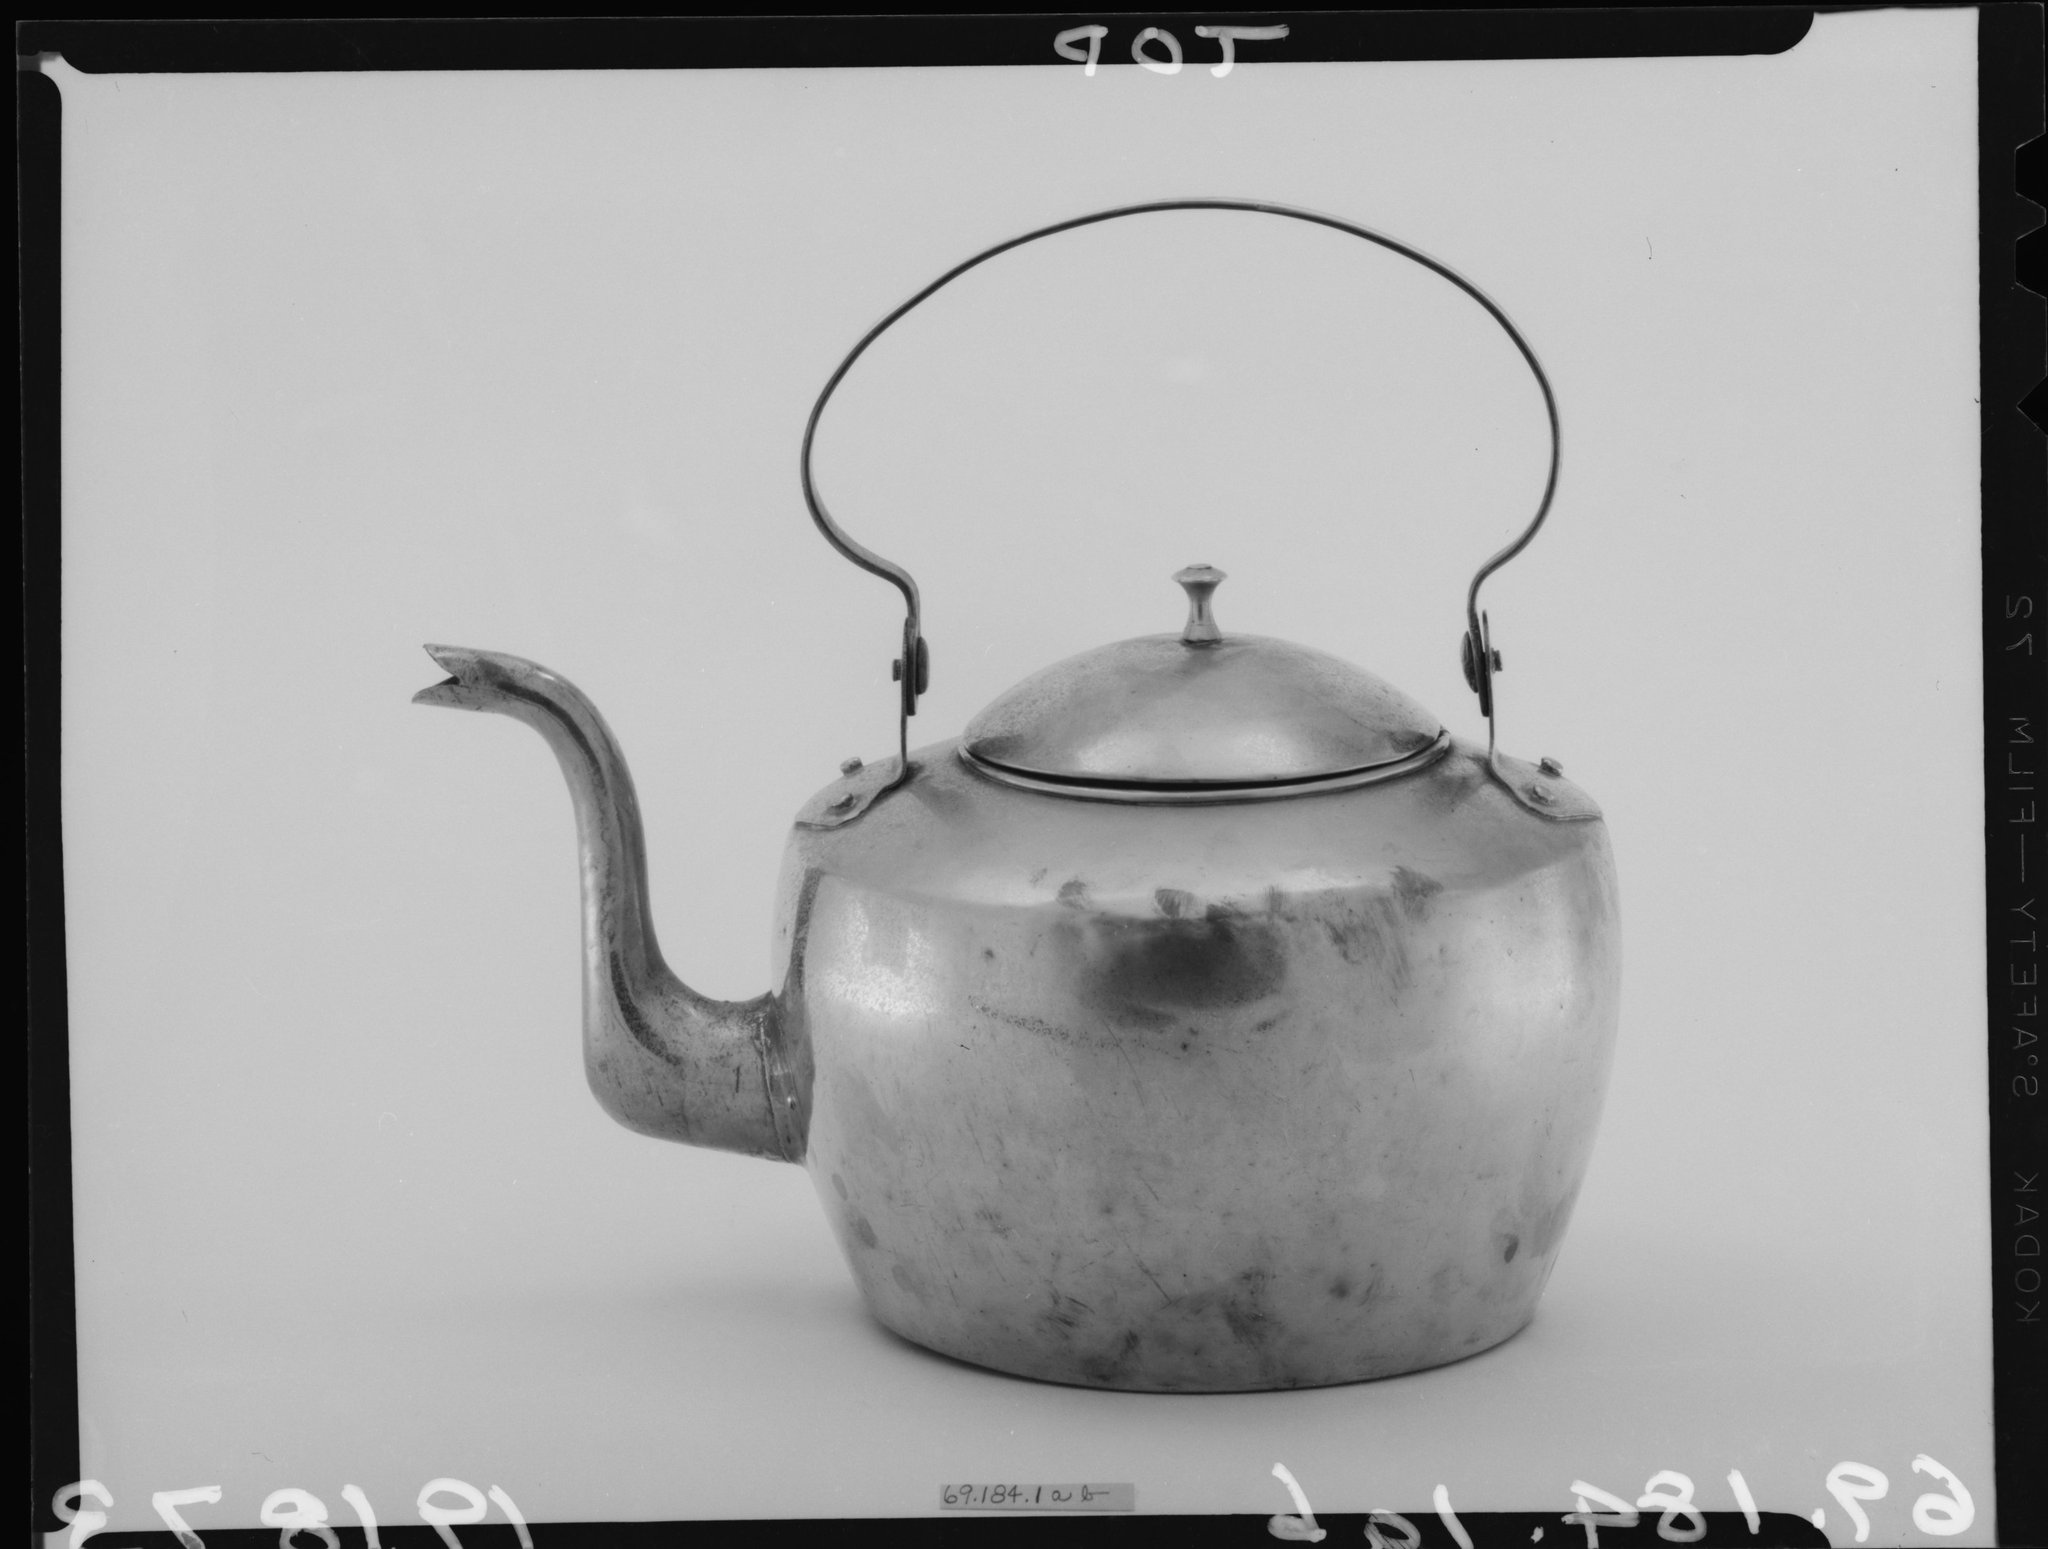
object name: teakettle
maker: j. dunn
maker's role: maker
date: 1800-1830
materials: copper